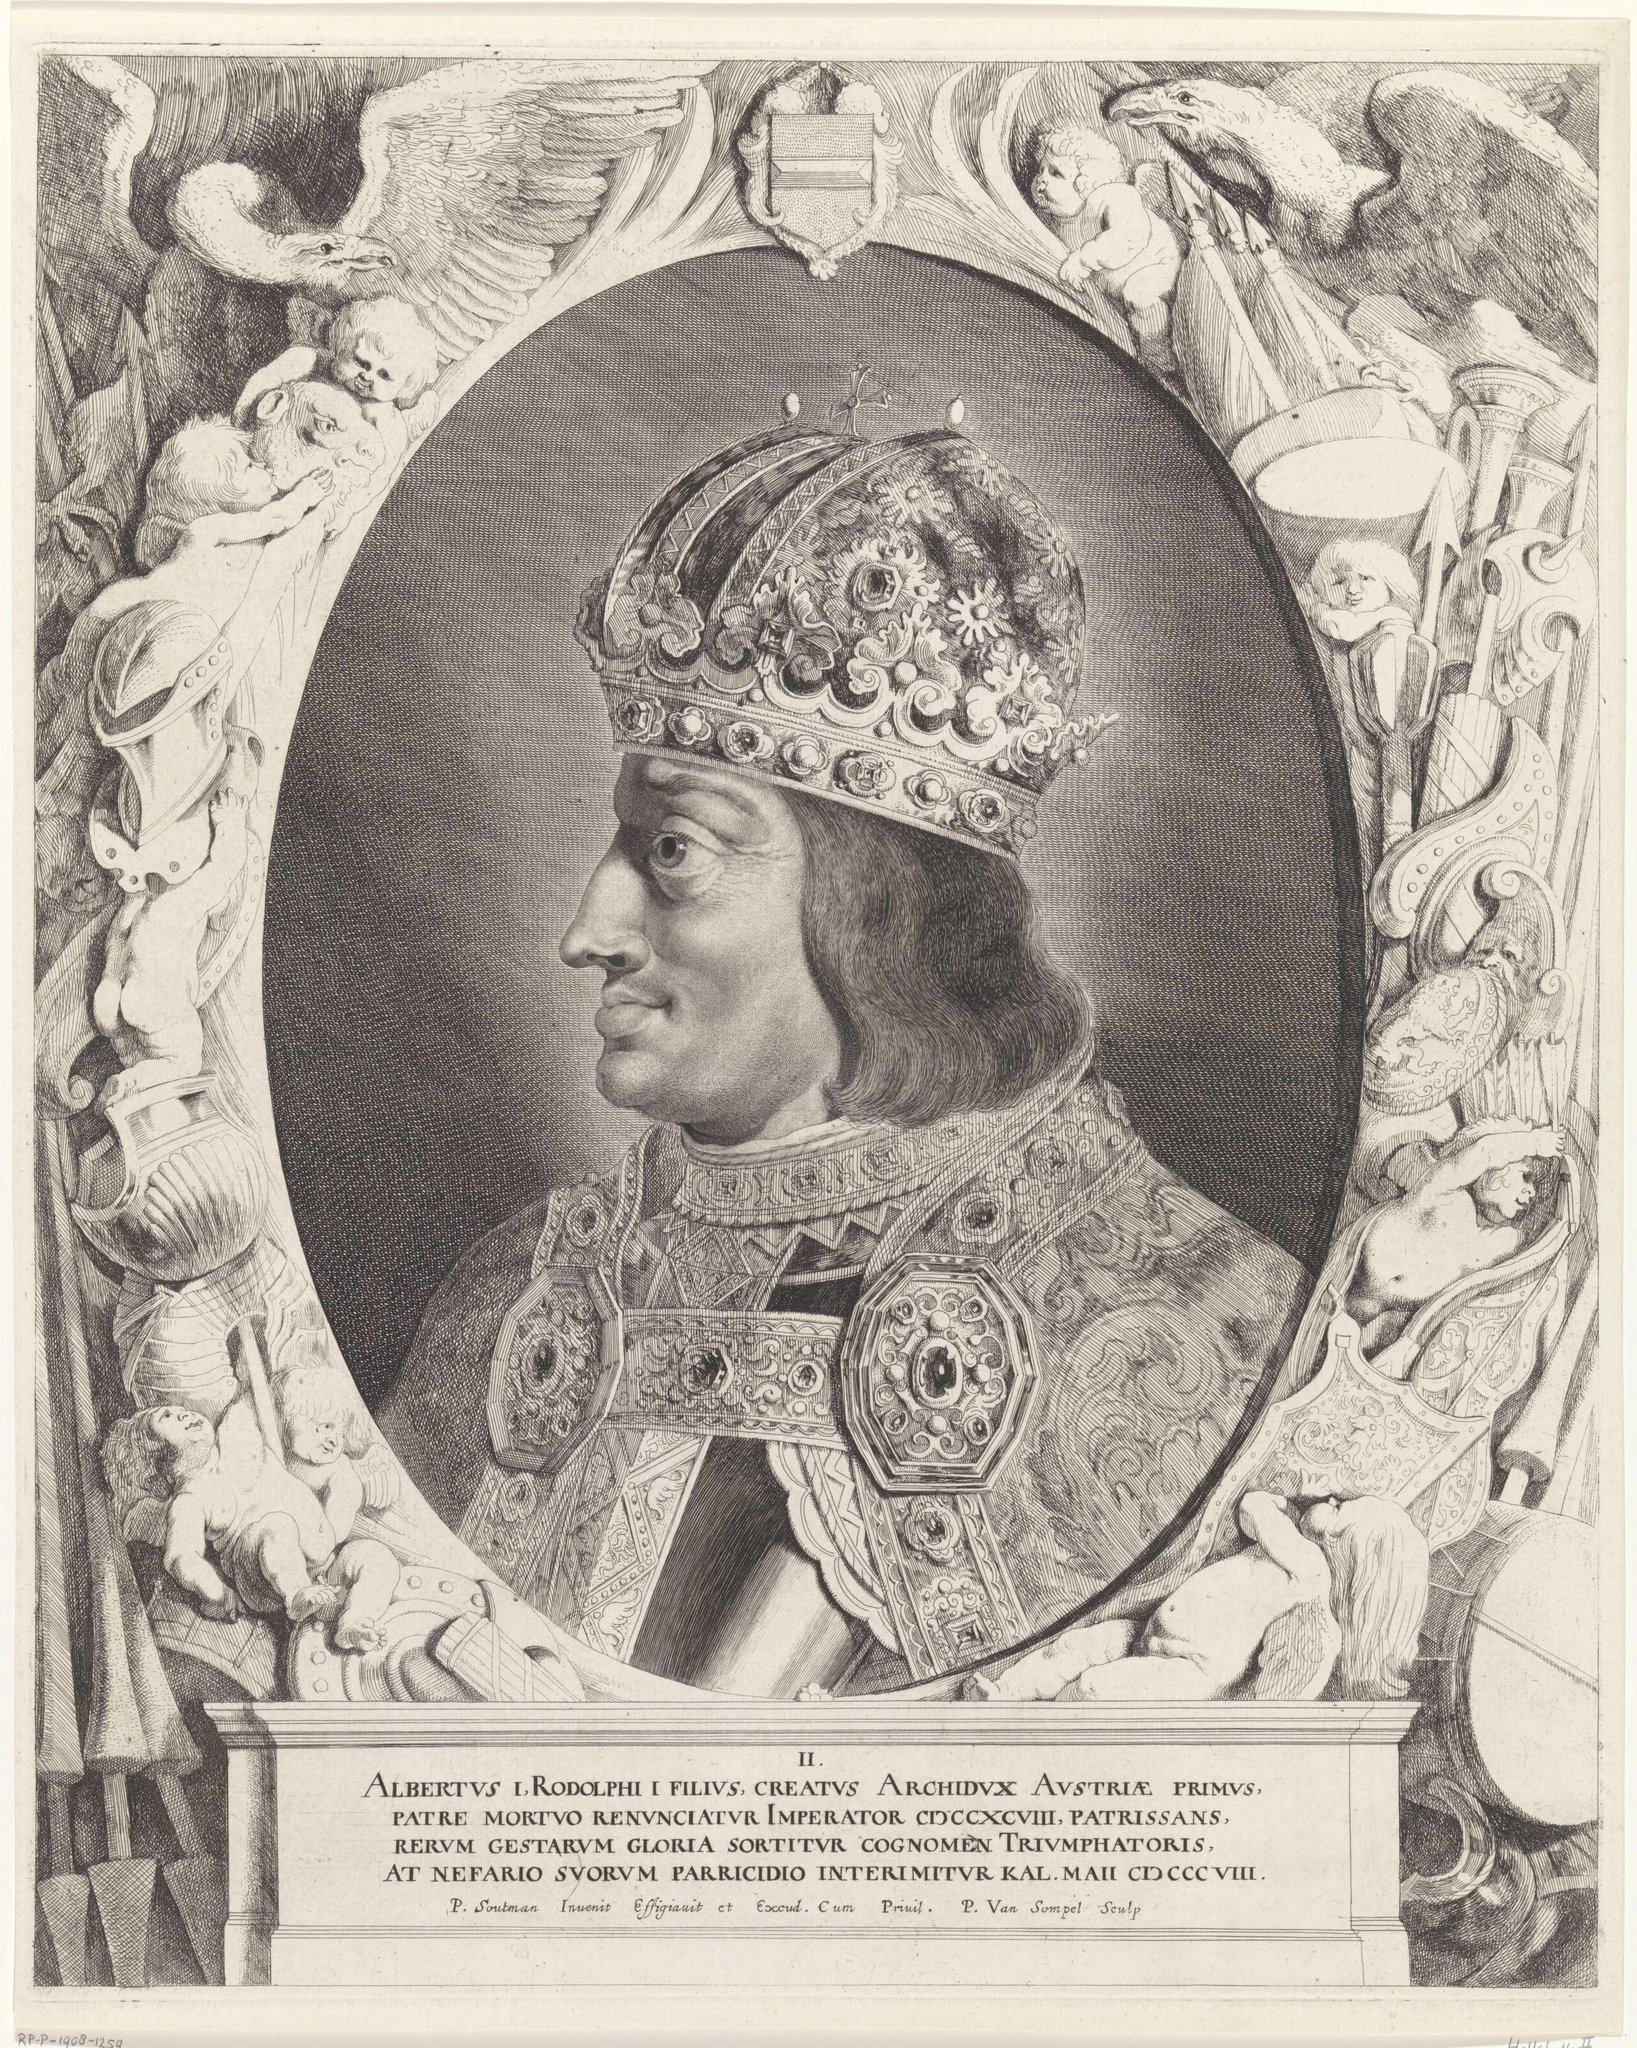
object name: print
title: Portret van Albrecht I van Habsburg (Rooms-Duits koning)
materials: paper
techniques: engraving, etching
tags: switzerland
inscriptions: collector's mark: Lugt 2228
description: Portret van Albrecht I van Habsburg (Rooms-Duits koning). Het portret wordt omlijst door een randversiering met putti, fasces en wapenuitrusting. In de beide bovenhoeken een adelaar, in het midden zijn wapenschild. Onder het portret een cartouche met in het Latijn zijn naam, titels en een korte levensbeschrijving.